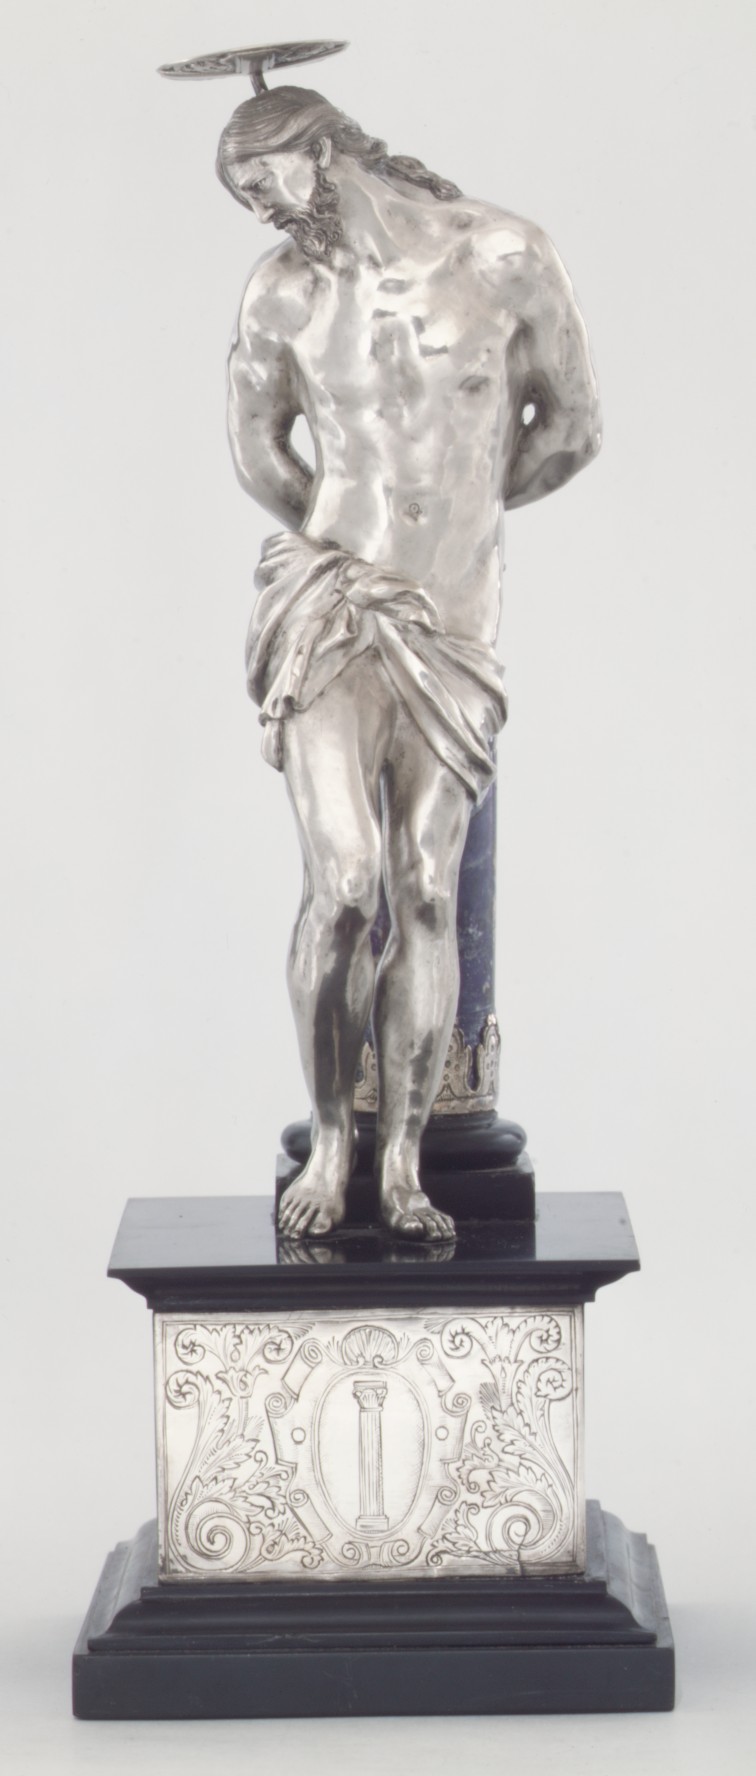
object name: statuette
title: Christ at the Column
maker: alessandro algardi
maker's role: artist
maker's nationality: italian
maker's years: 1598-1654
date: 1634-1666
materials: lapis lazuli, marble, silver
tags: christ,coat of arms